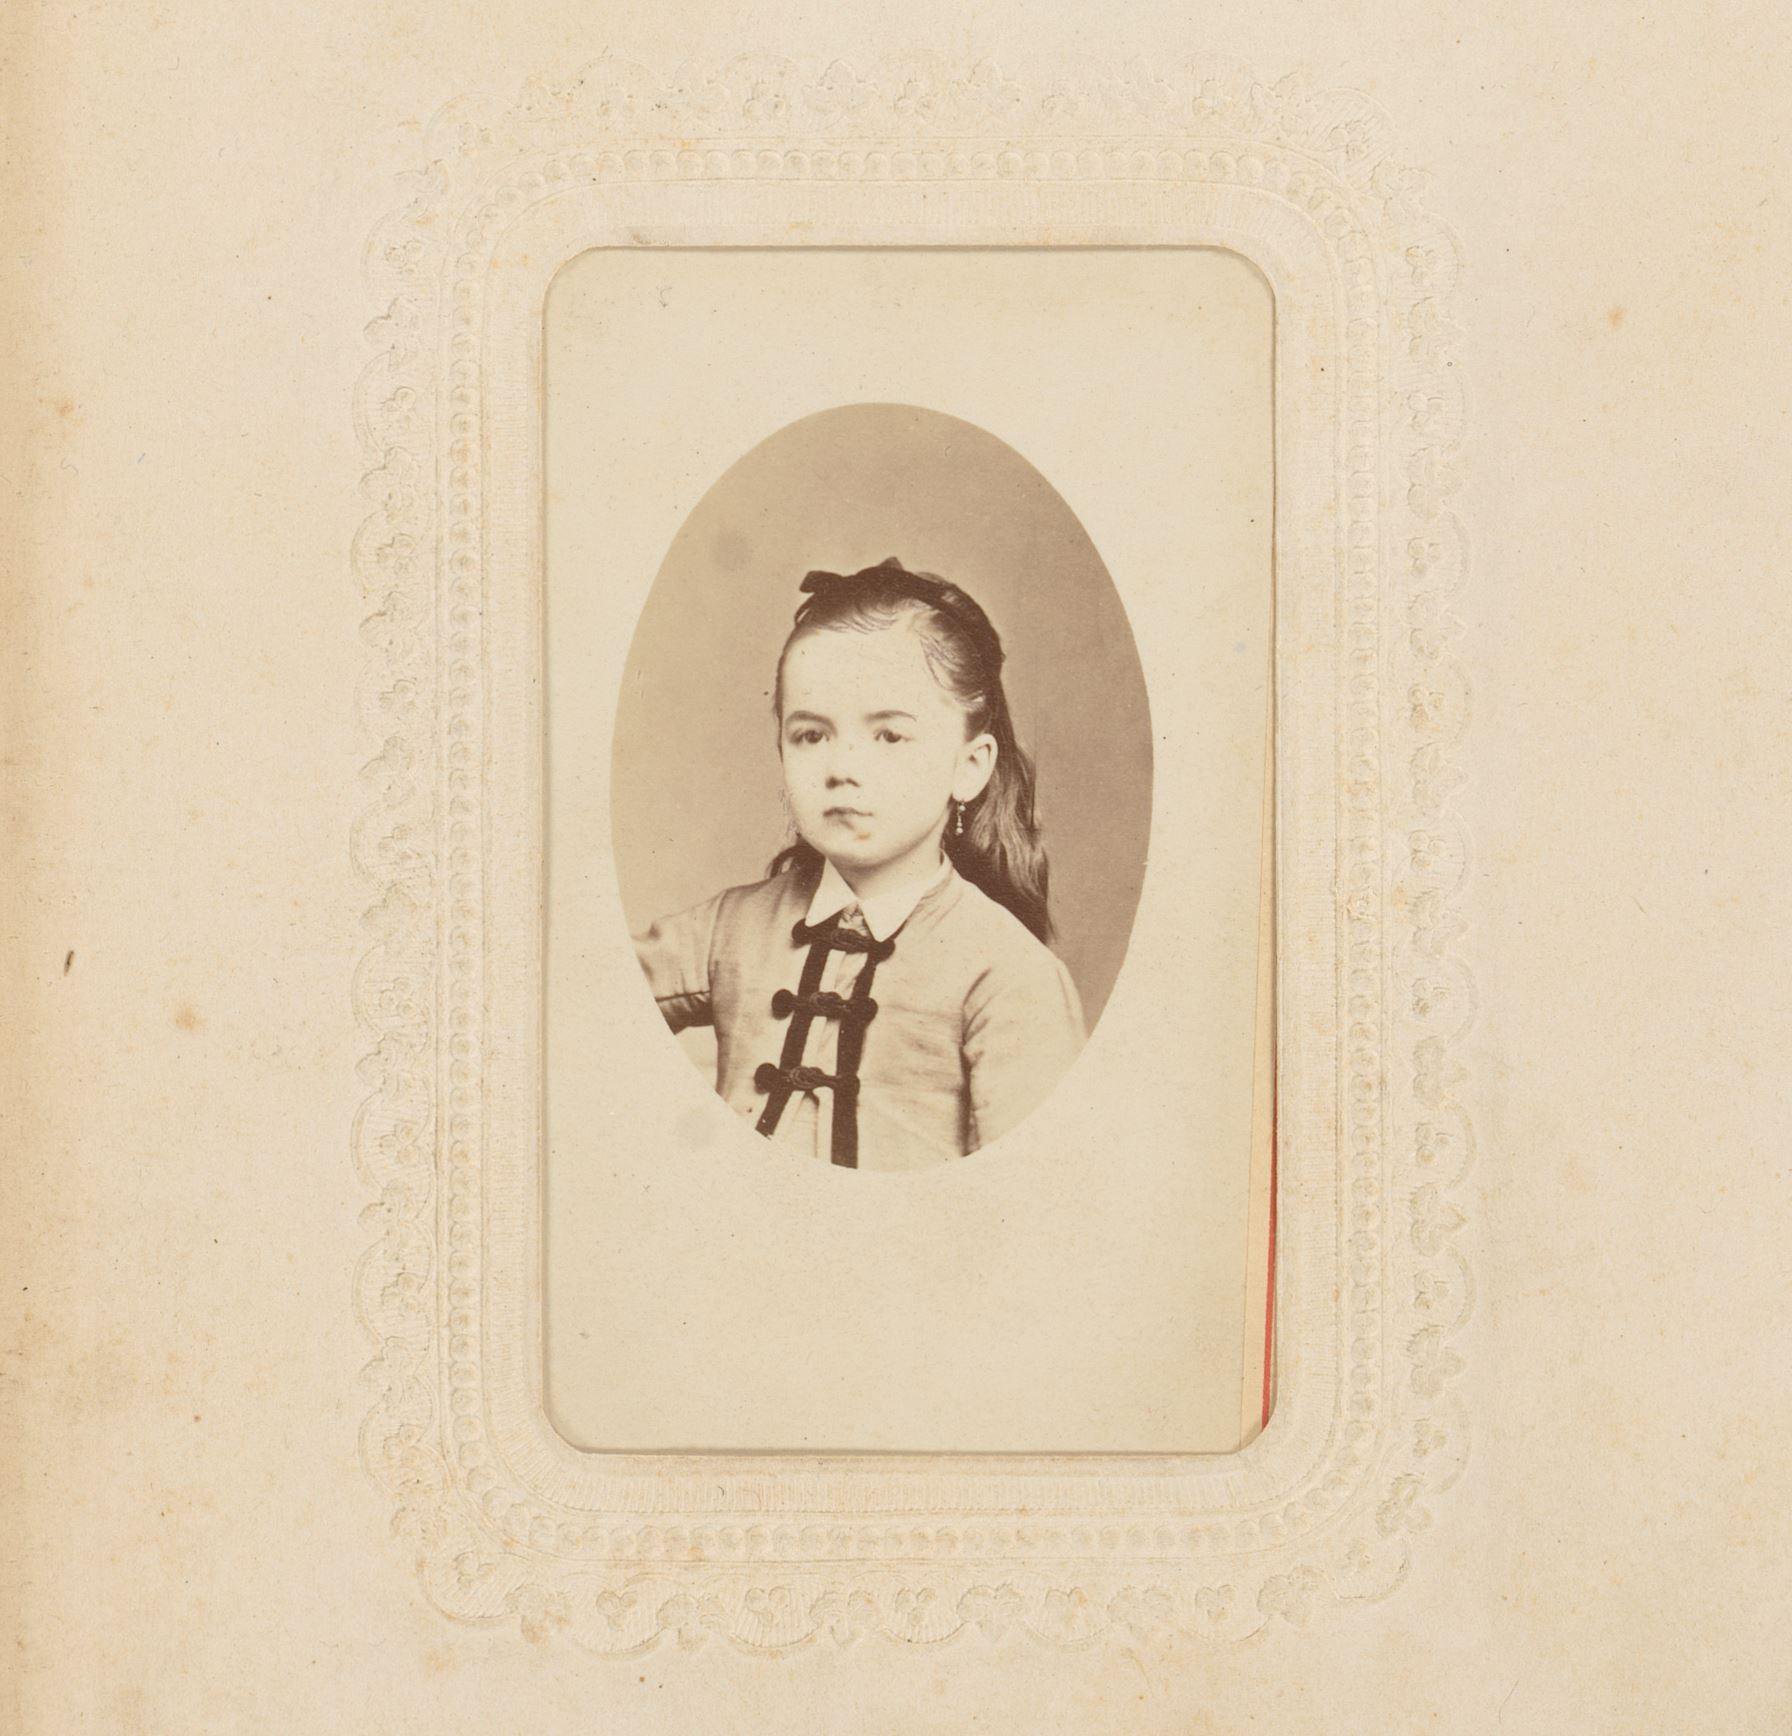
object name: photograph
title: Portret van een meisje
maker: albert delabarre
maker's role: musician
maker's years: 1809-1885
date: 1866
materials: cardboard, photographic support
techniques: albumen print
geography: brussels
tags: historical persons - bb - woman, girl (child between toddler and youth)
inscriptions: inscription: ‘Photographie Parisienne/ 36, Rue Fossé aux Loups, 36/ (Pace de la Monnaie)/ Bruxelles’